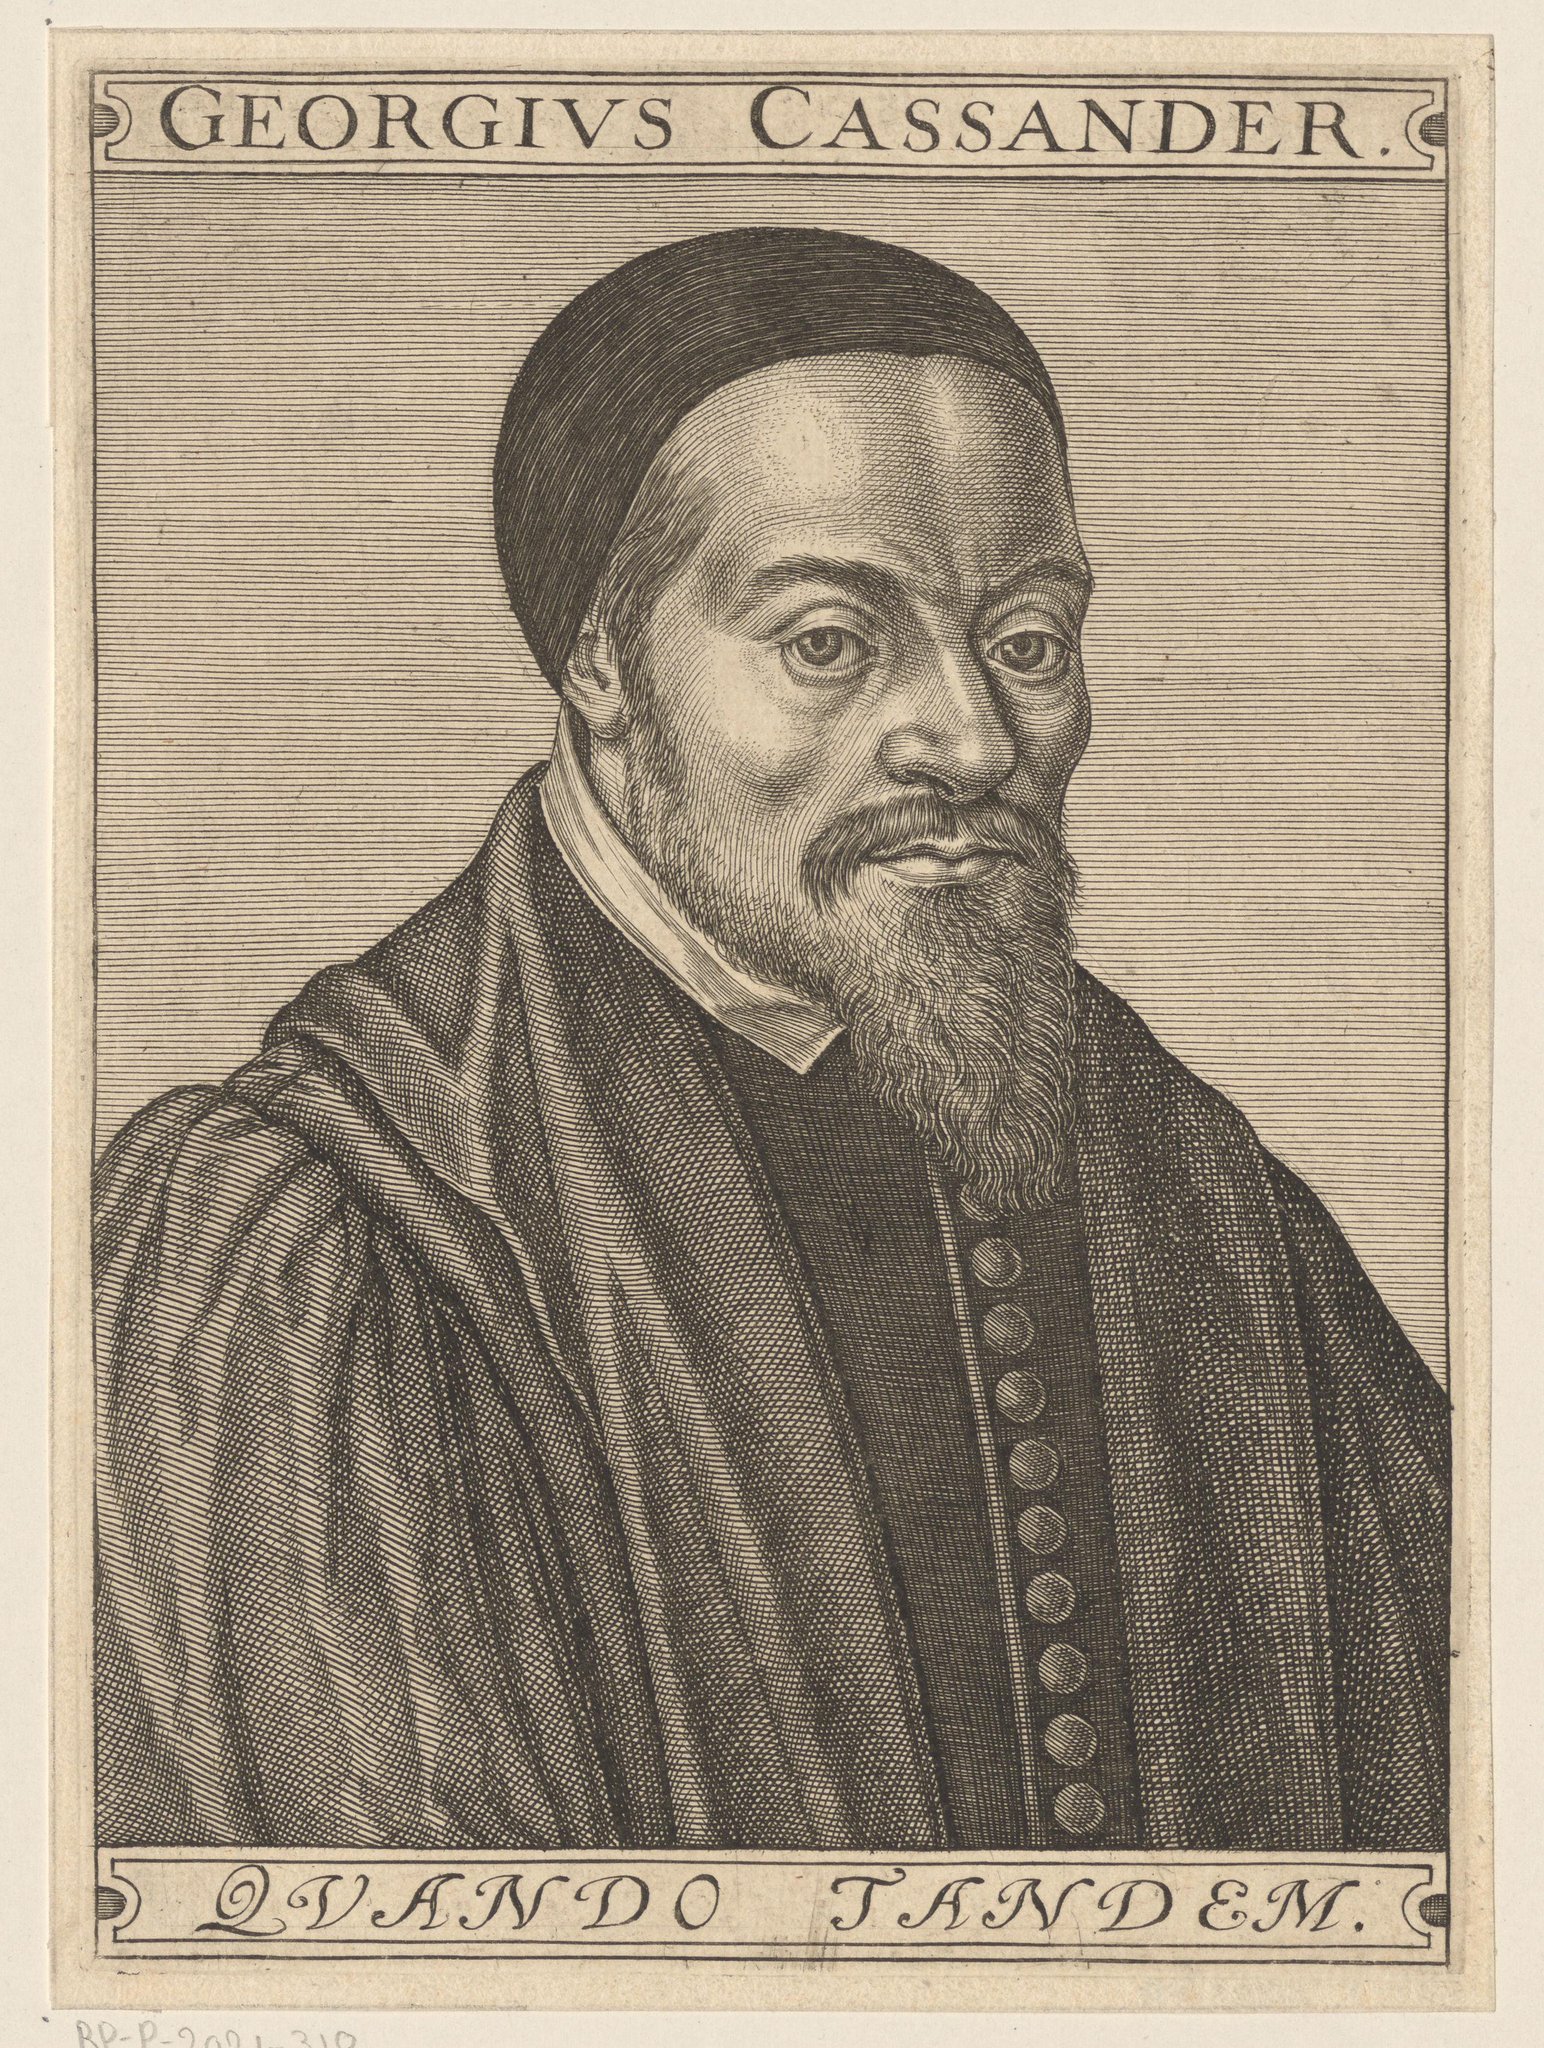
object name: print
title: Portret van Joris Cassander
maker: Anonymous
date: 1530-1649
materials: paper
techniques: engraving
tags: bruges, cologne, theologian, historical persons